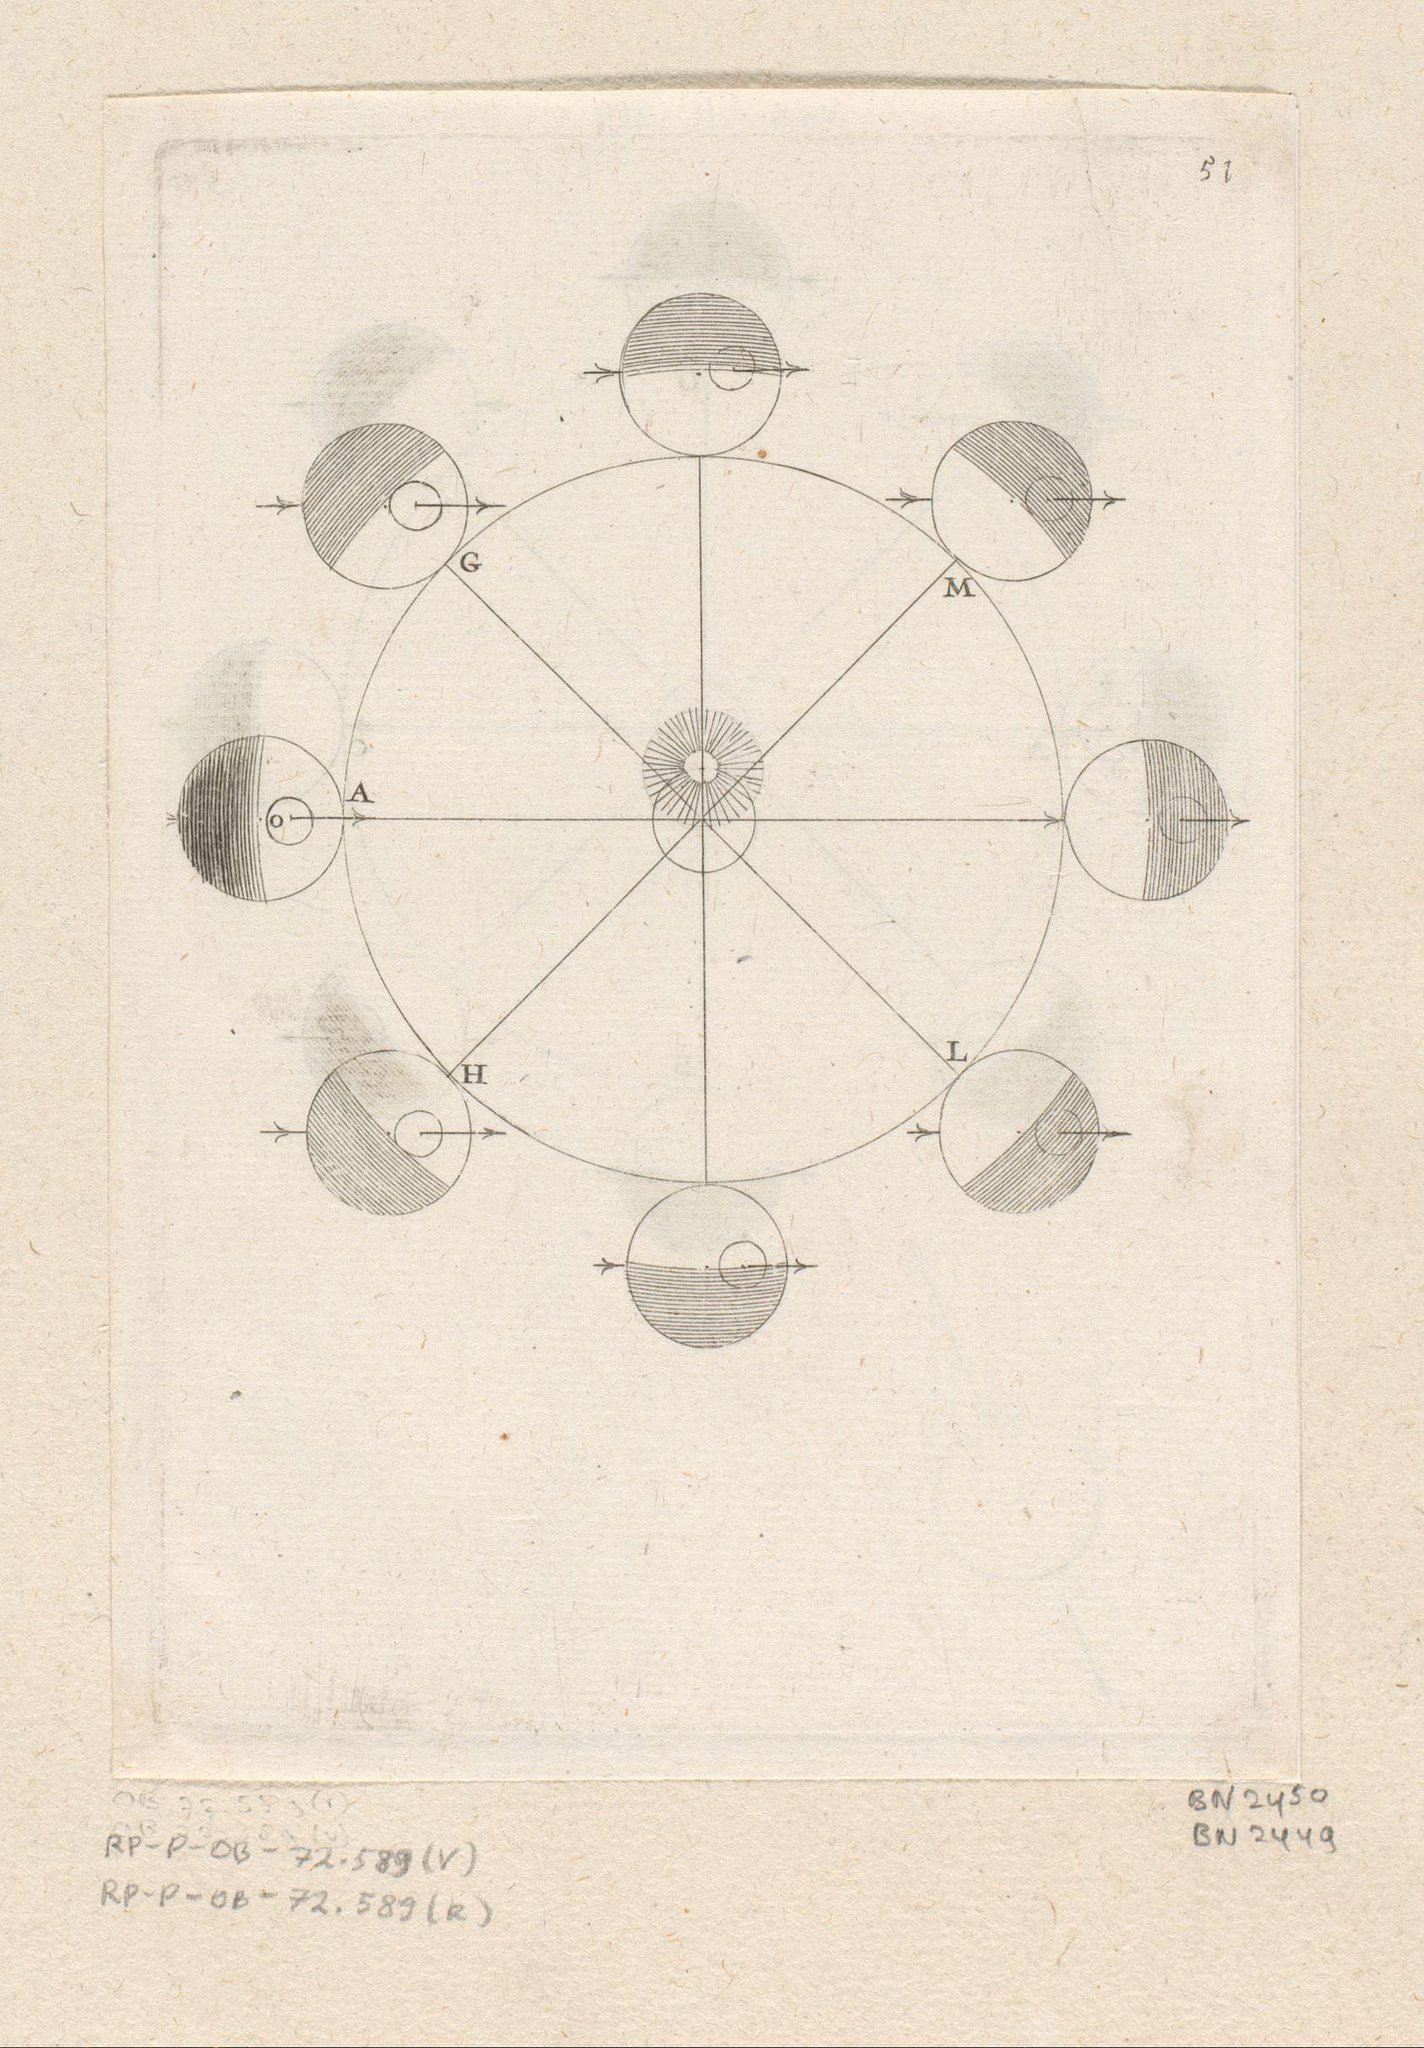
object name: book illustration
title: Beweging van de Aarde rond de Zon en de evolutie van de dagen en nachten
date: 1706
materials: paper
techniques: etching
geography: paris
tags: earth, world as celestial body, sun as celestial body, day and night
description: Prent uit: Leclerc, Sébastien. Nouveau systeme du monde conforme à l'Ecriture sainte. Où les phénomènes sont expliquez sans excentricité de mouvement (...). Paris: Pierre Giffart, 1706.